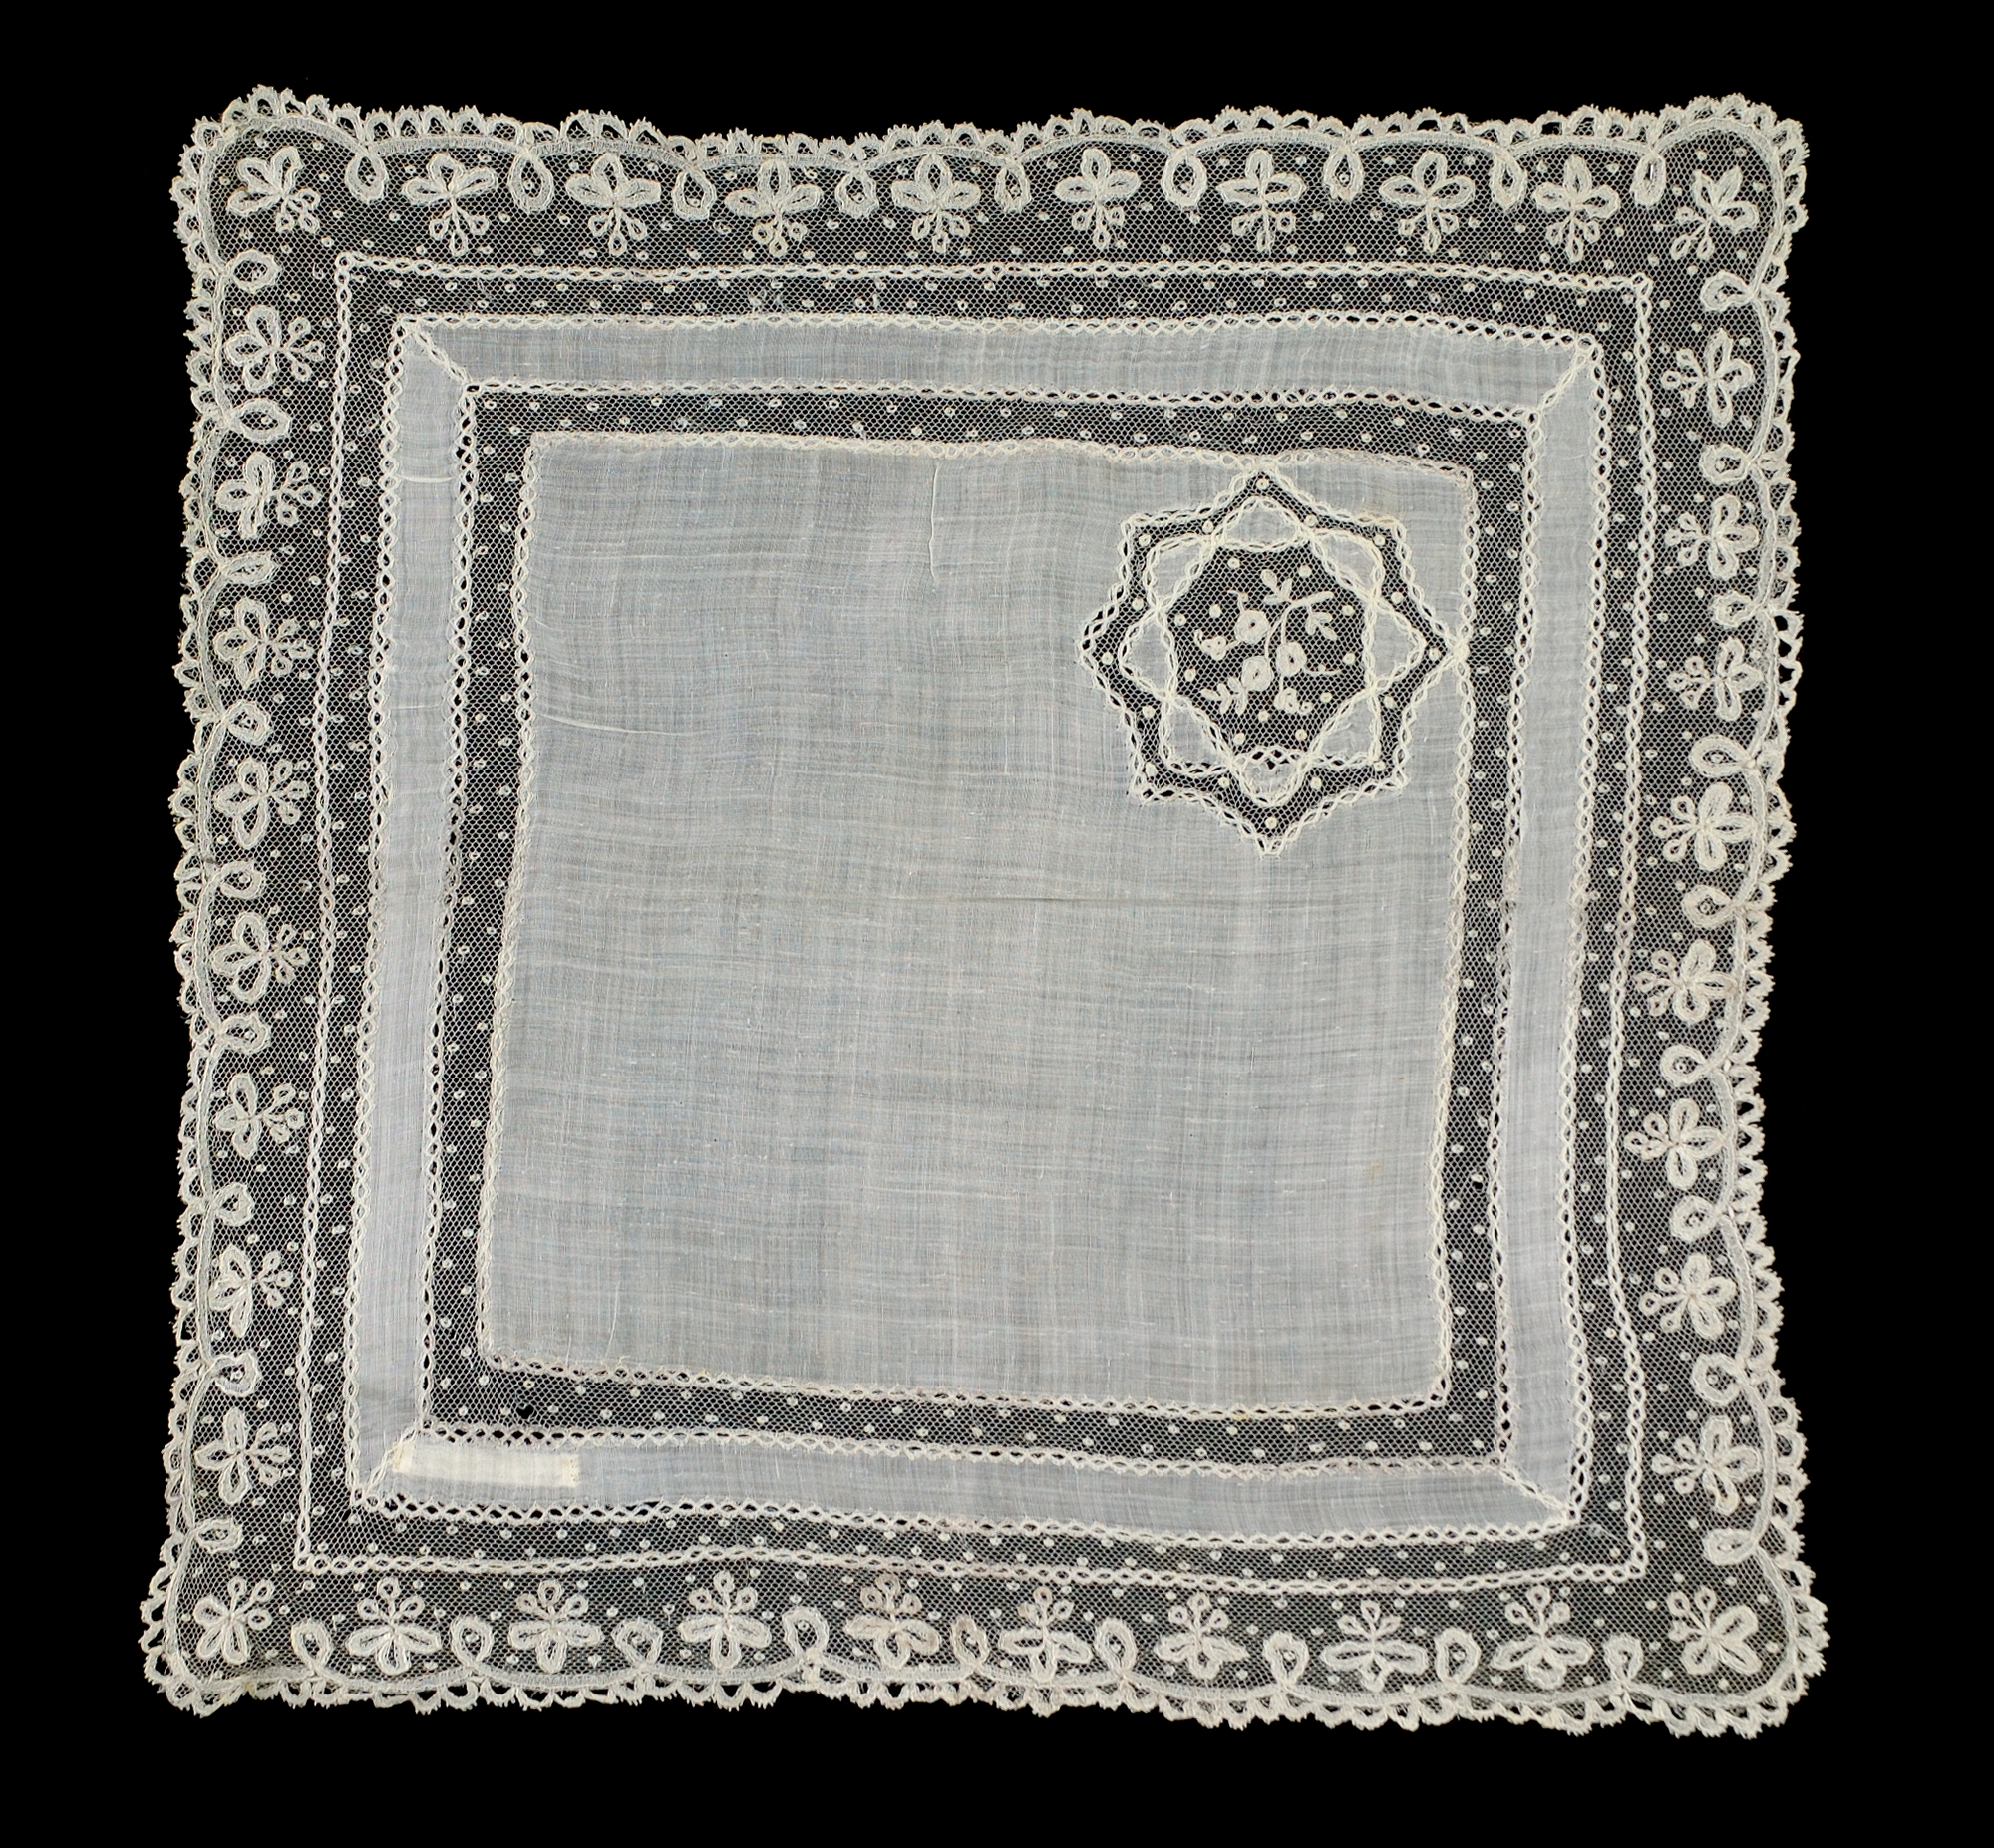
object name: handkerchief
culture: american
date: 1876-1900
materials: cotton